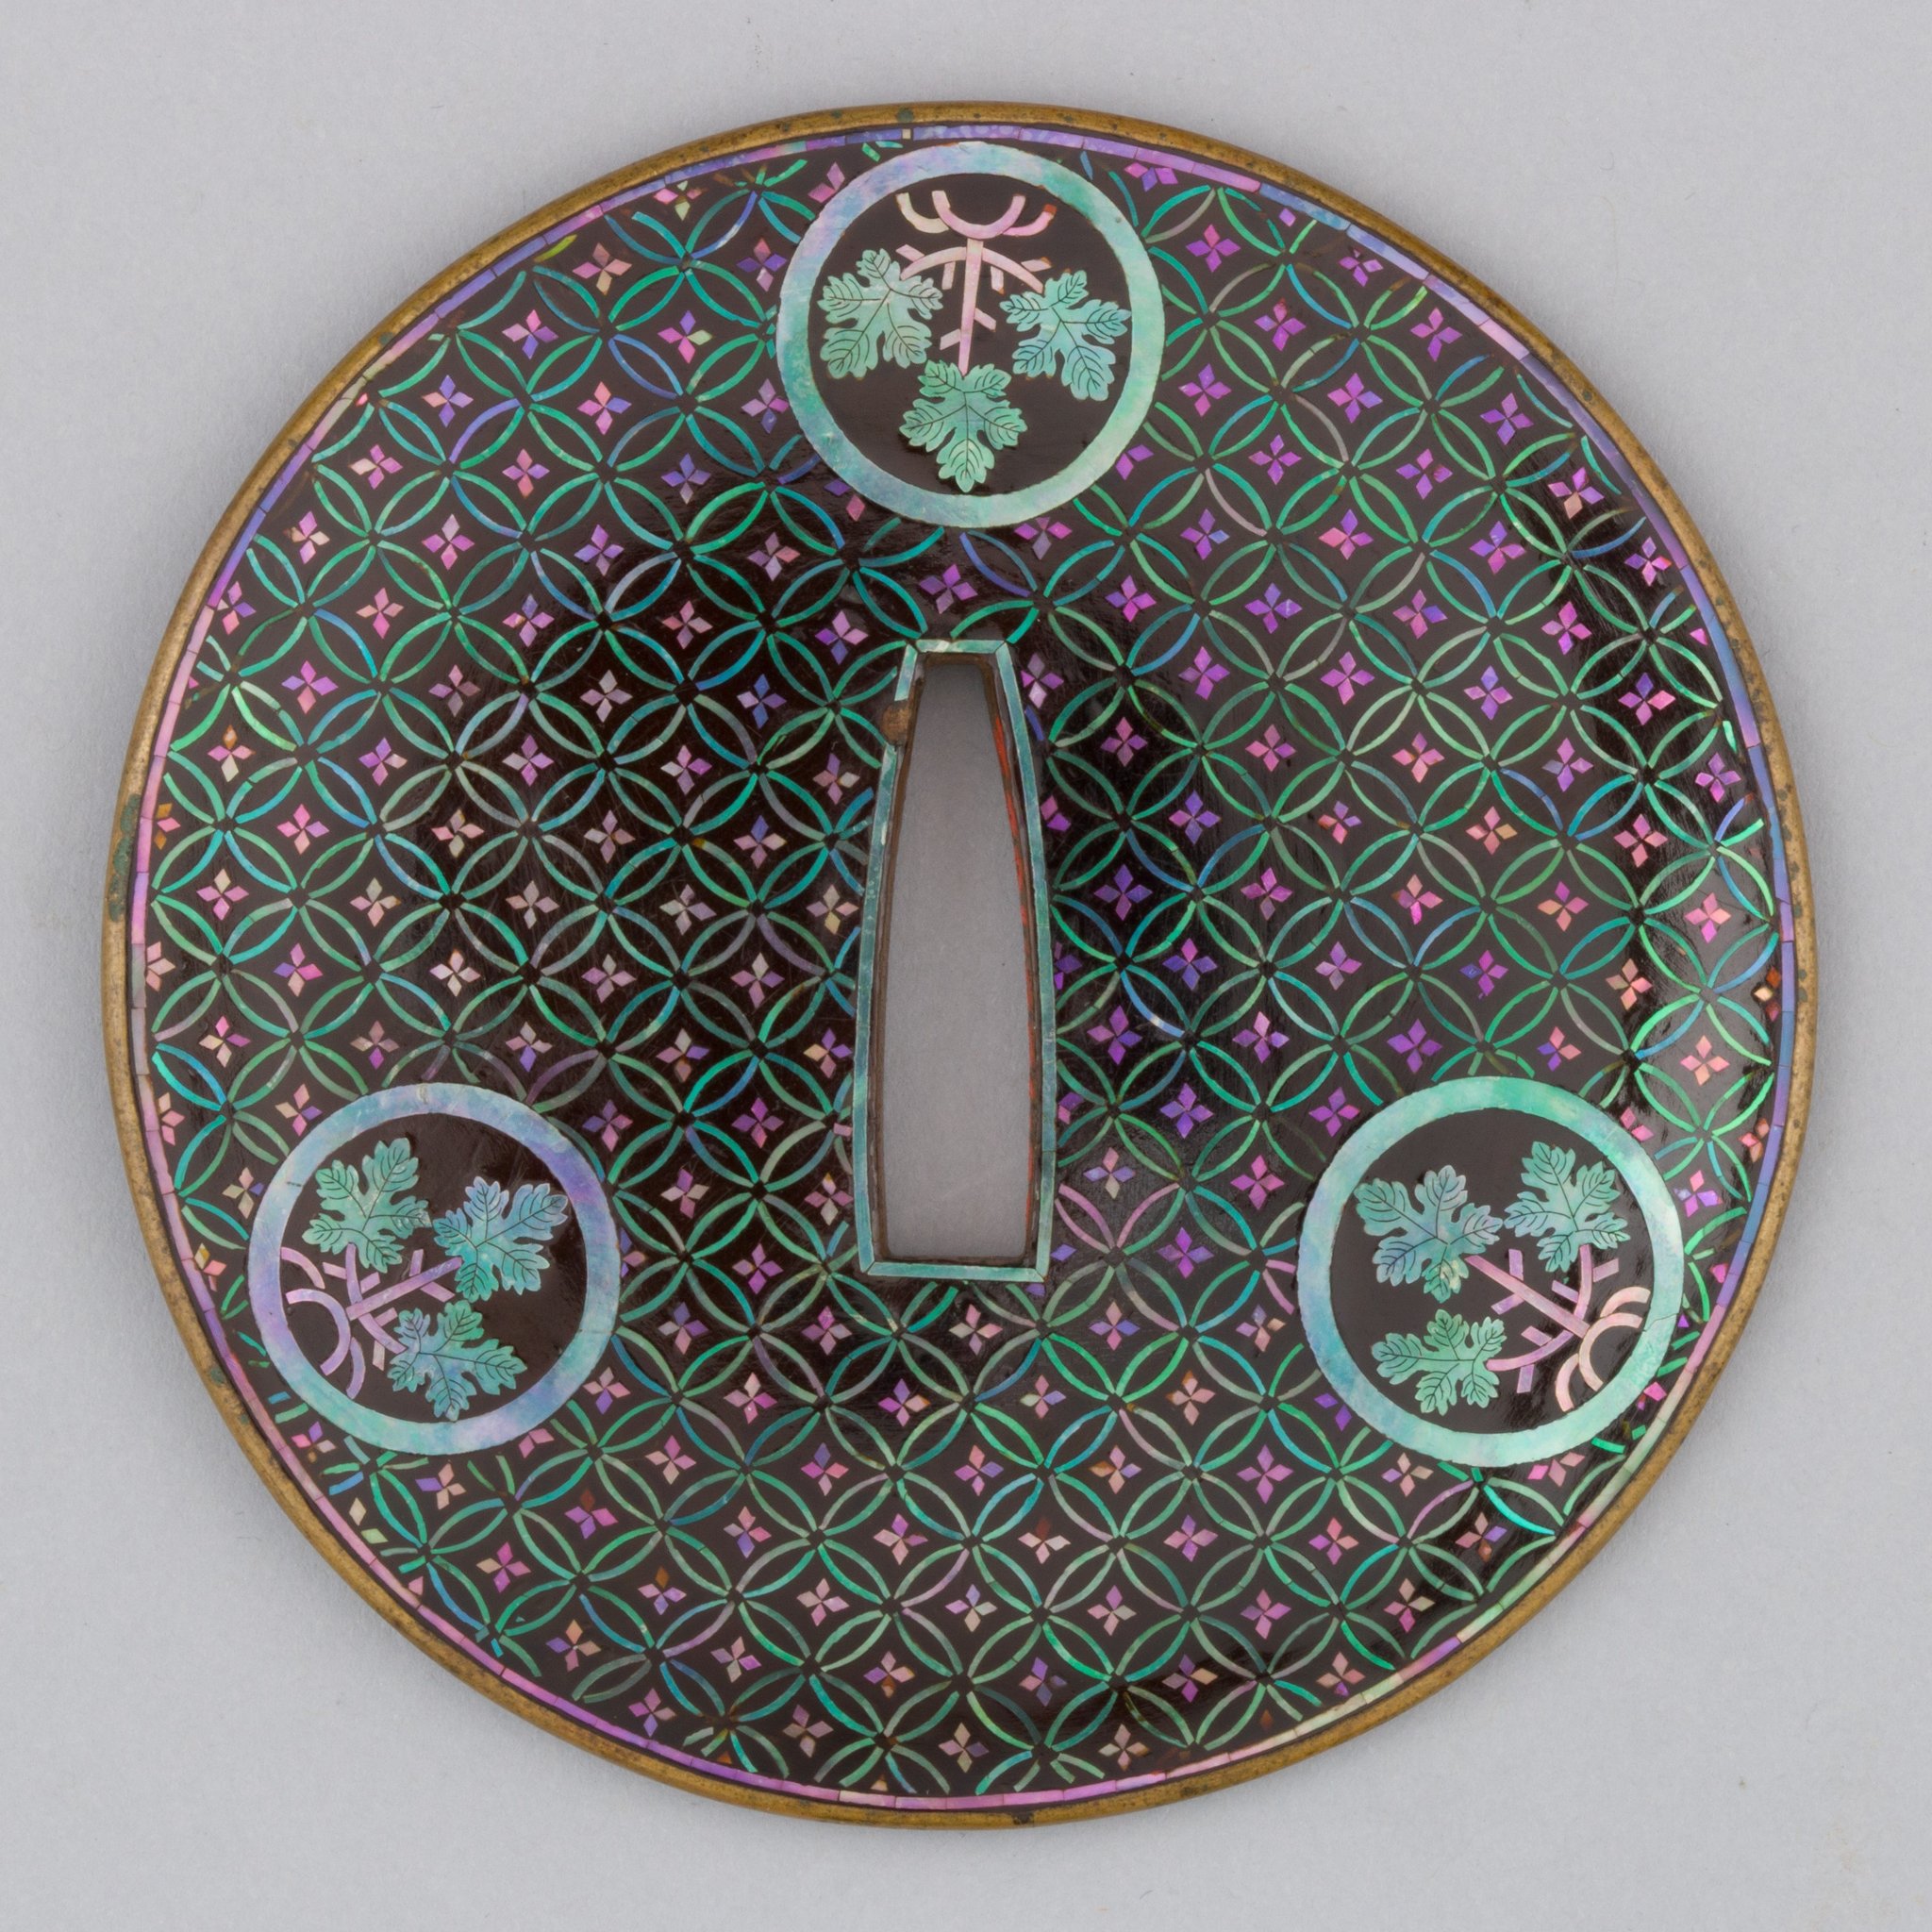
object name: sword guard tsuba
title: Sword Guard (Tsuba)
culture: japanese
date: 1615-1868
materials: copper, copper alloy, gold alloy, lacquer, shell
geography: japan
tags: leaves